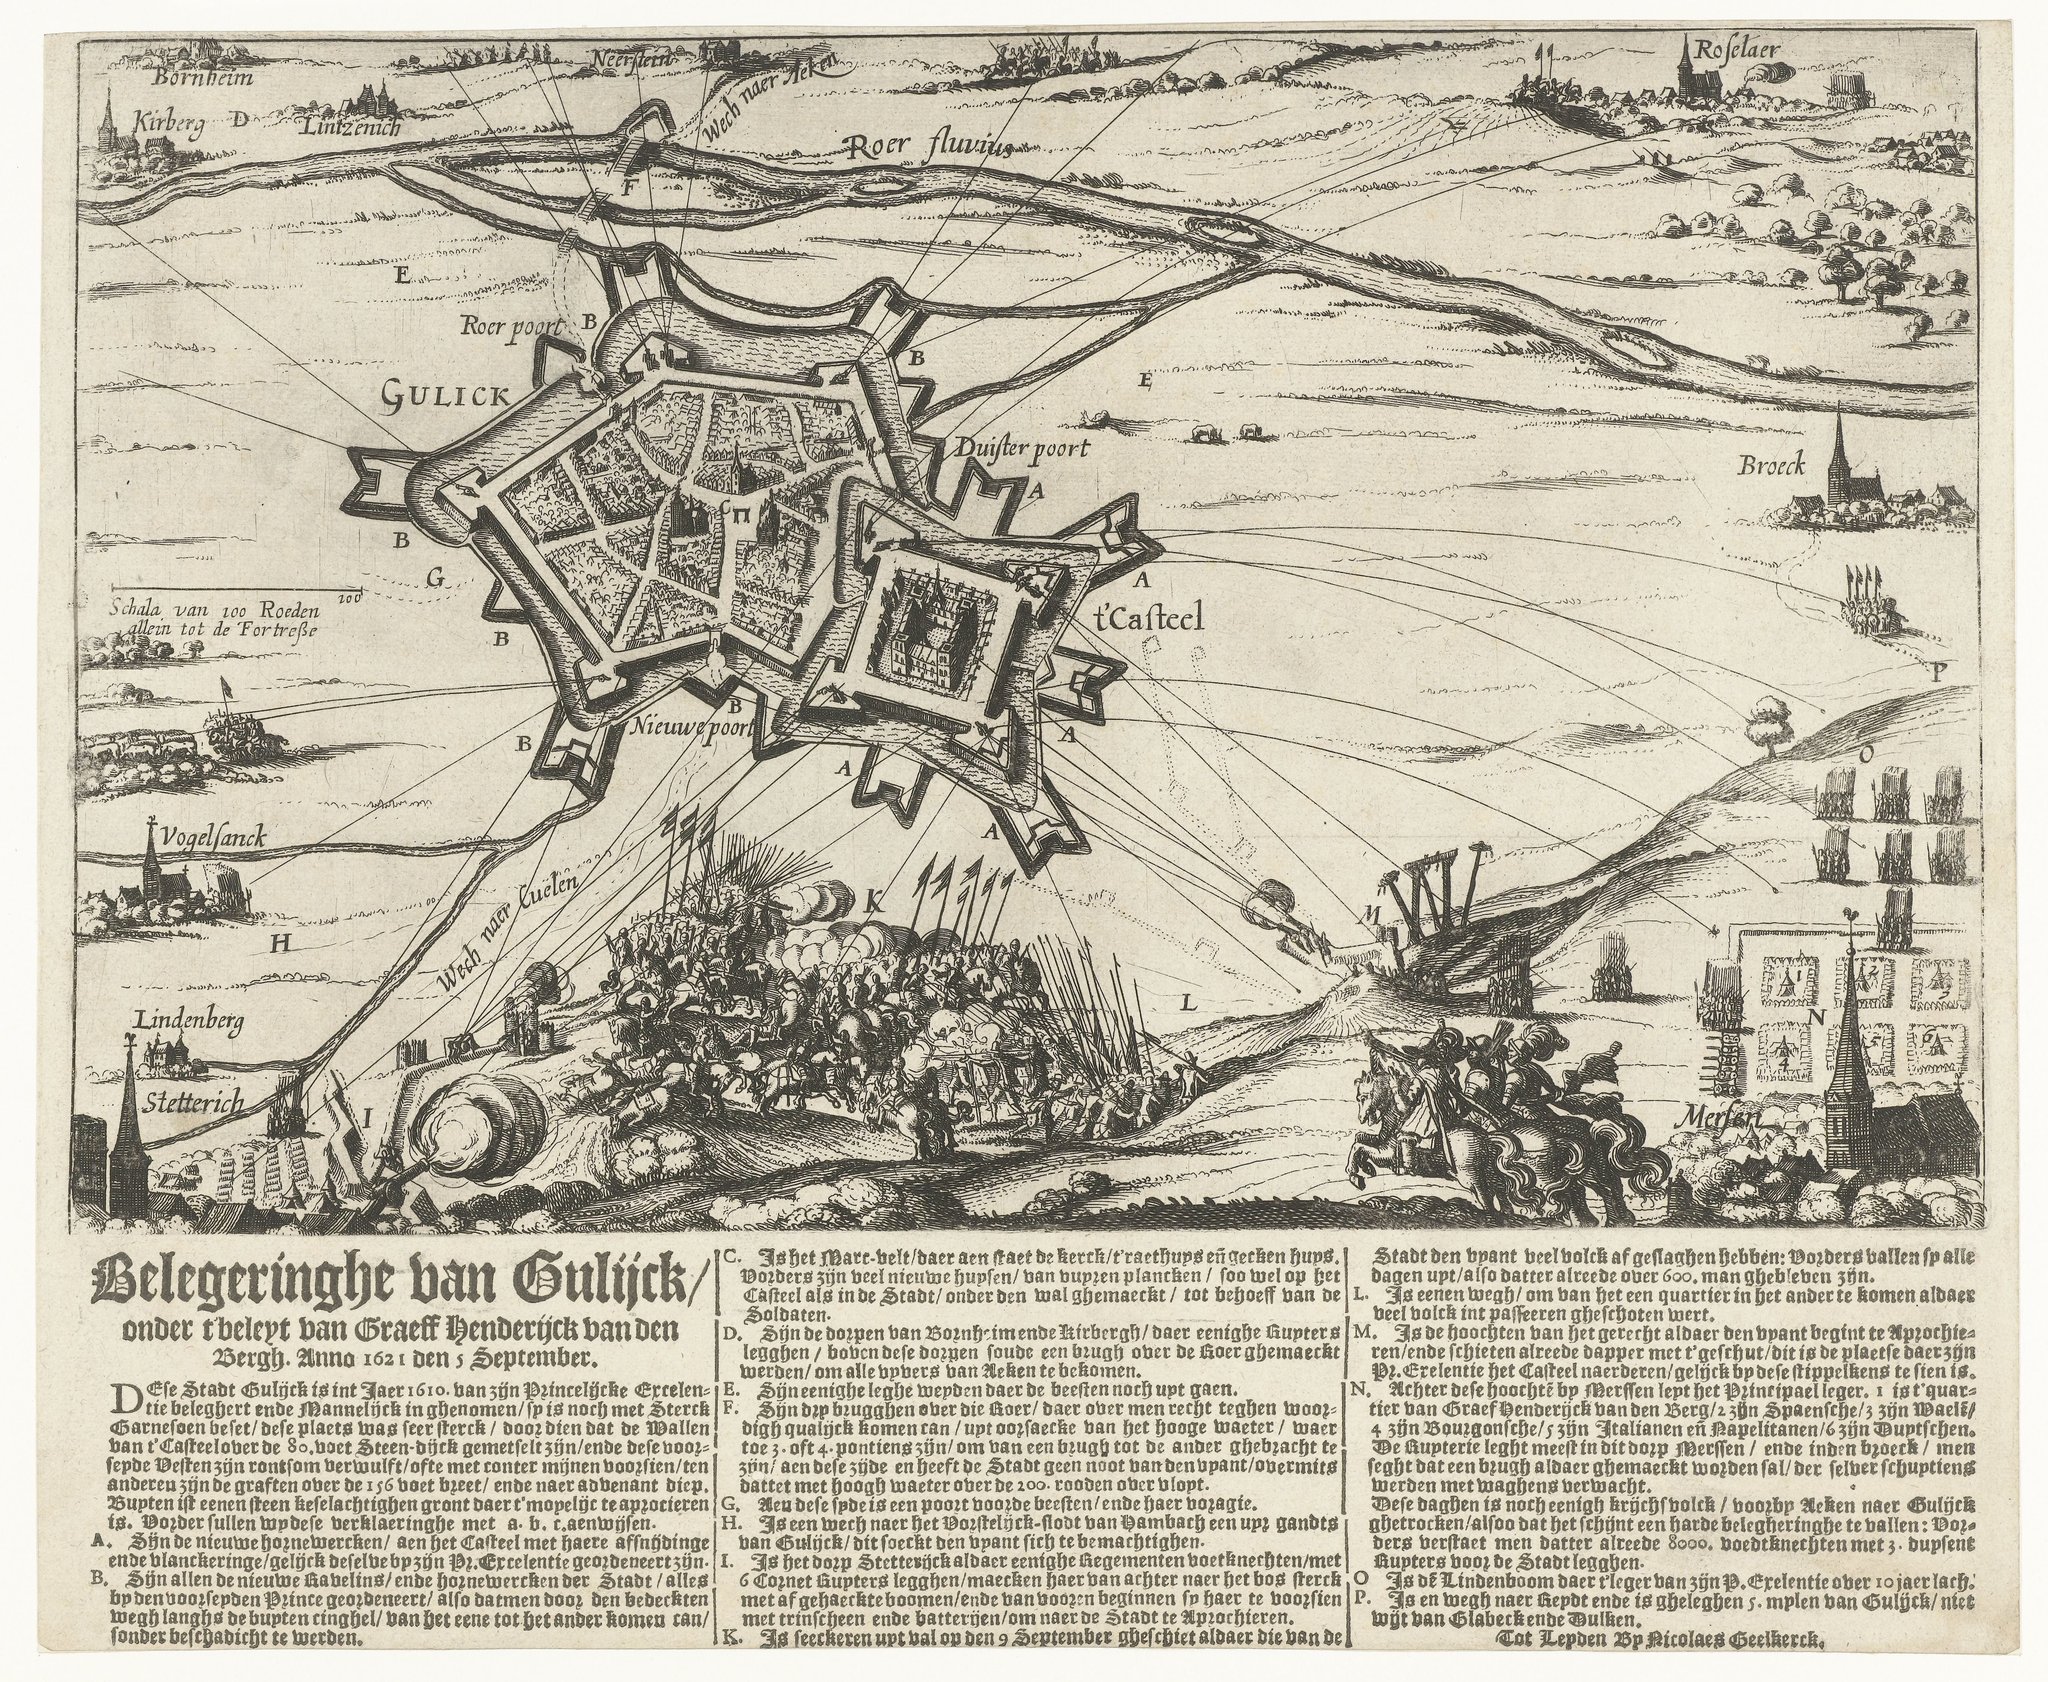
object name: print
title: Belegeringhe van Gulijck / onder t'beleyt van Graeff Henderijck van den Bergh. Anno 1621 den 5 September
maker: nicolaes van geelkercken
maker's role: print maker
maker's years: 1585-1656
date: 1621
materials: paper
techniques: etching, letterpress printing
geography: leiden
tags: earl, siege, position war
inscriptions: date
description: Beleg van Gulik door het Spaanse leger onder graaf Hendrik van den Bergh, 5 september 1621. Plan van de stad met het kasteel in het omliggende land. Op de voorgrond een ruitergevecht. Onderaan de legenda A-P in 3 kolommen in het Nederlands.